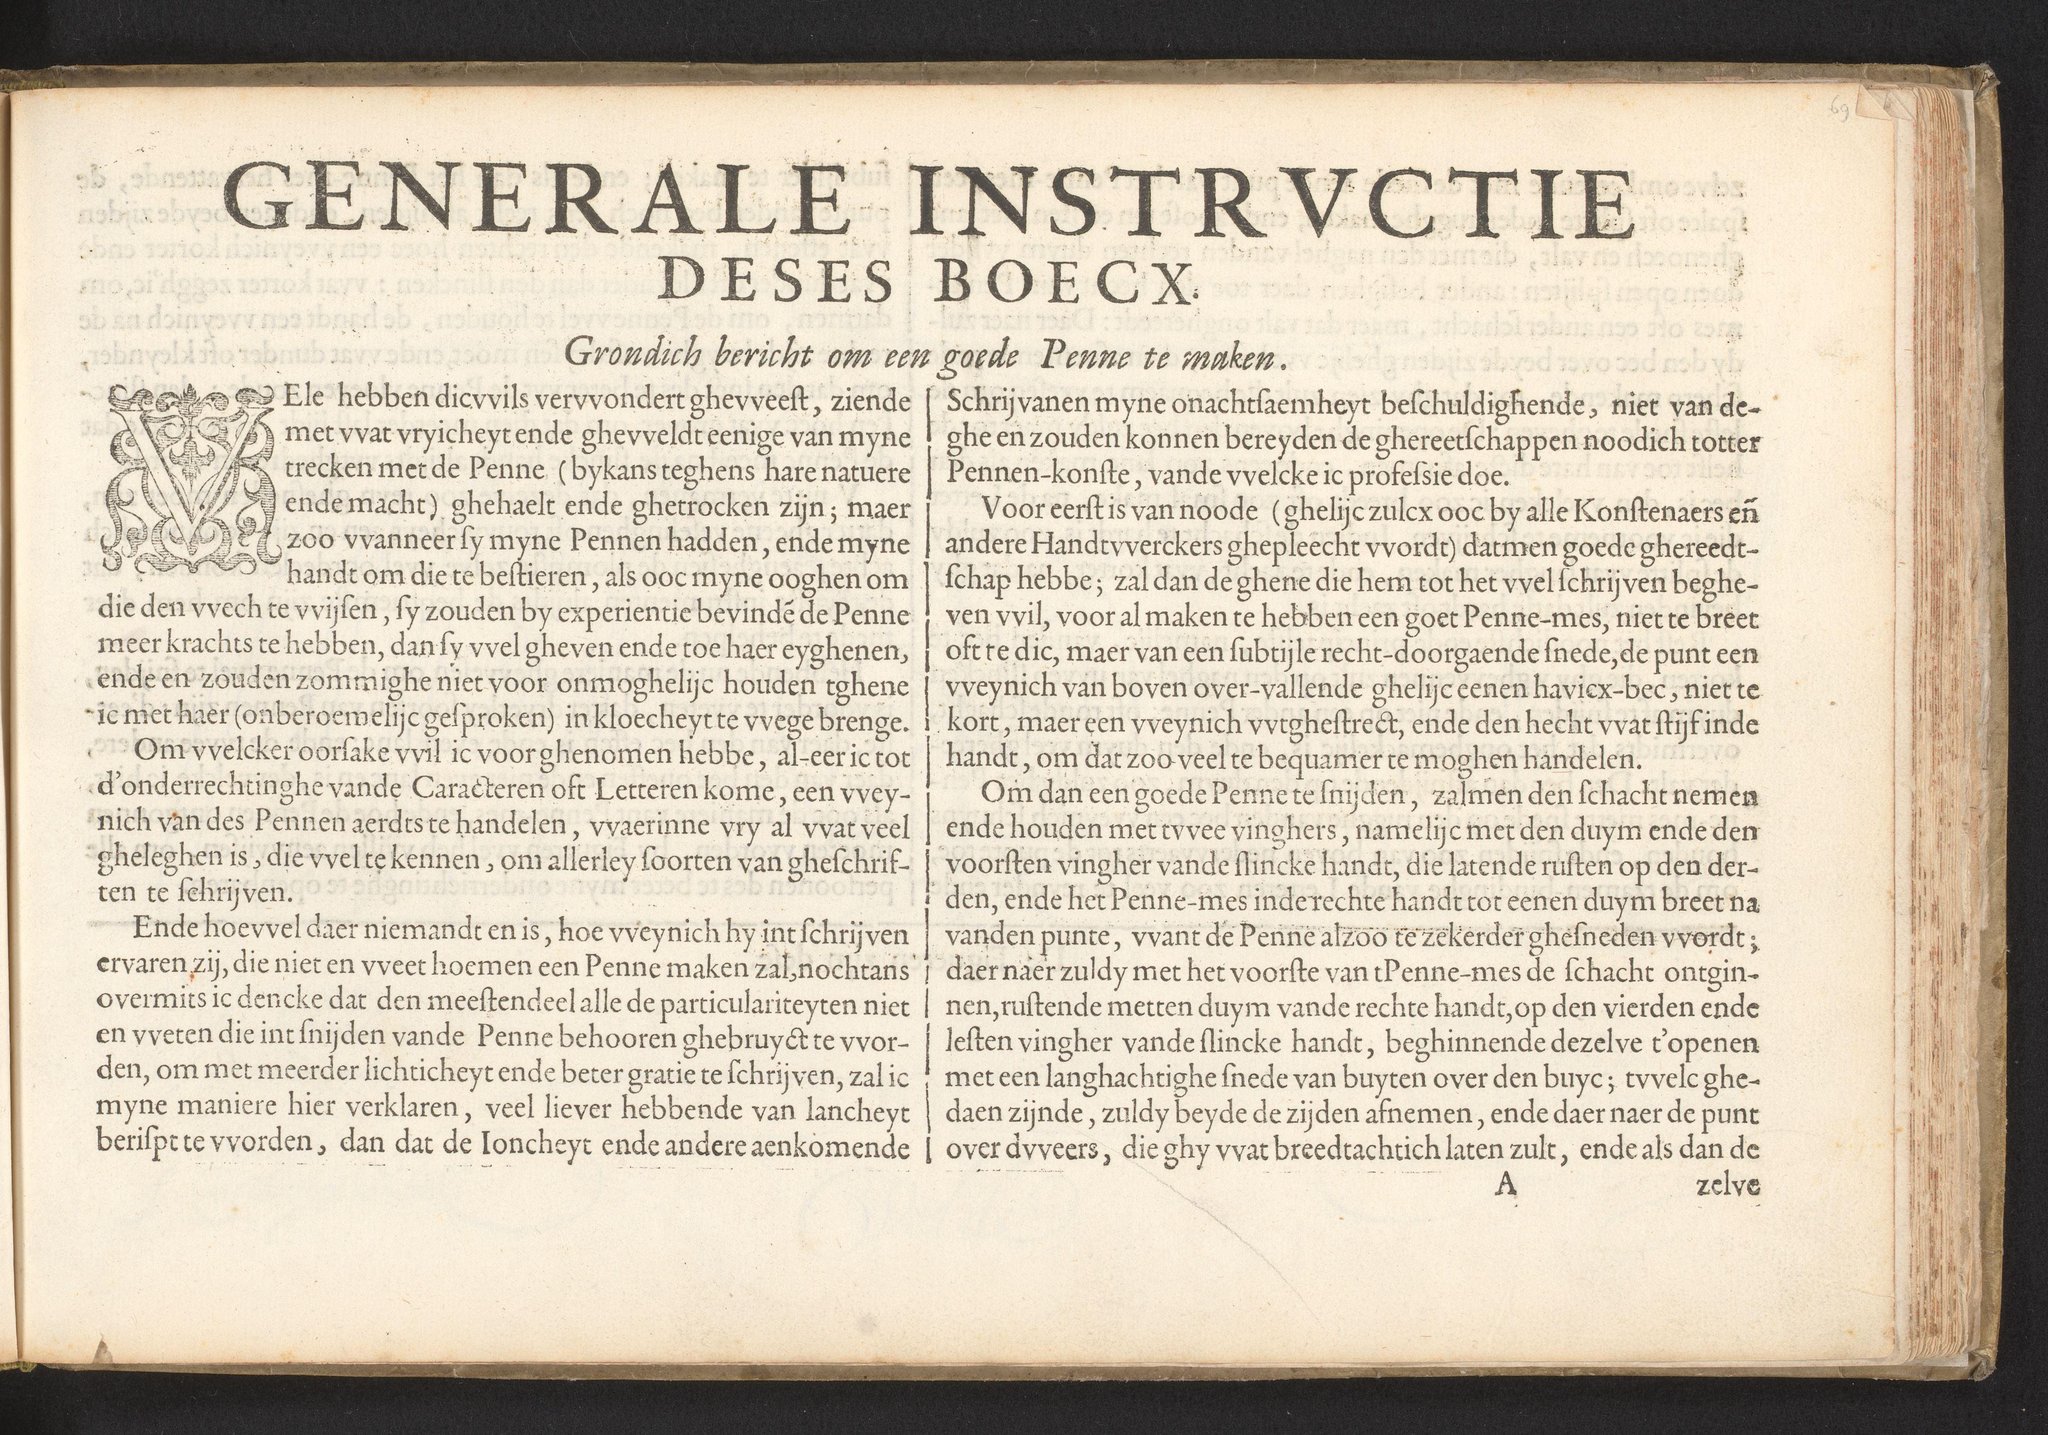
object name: album leaf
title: Generale instructie deses boecx. Grondich bericht om een goede penne te maken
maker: jan van de velde (i)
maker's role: painter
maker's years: 1568-1623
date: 1605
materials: paper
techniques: letterpress printing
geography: rotterdam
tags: initial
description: Tekstblad met een instructie hoe je een goede rietpen maakt, pagina 1 van 2. De tekst begint met een gedecoreerde initiaal V. Het tekstblad maakt deel uit van een album.